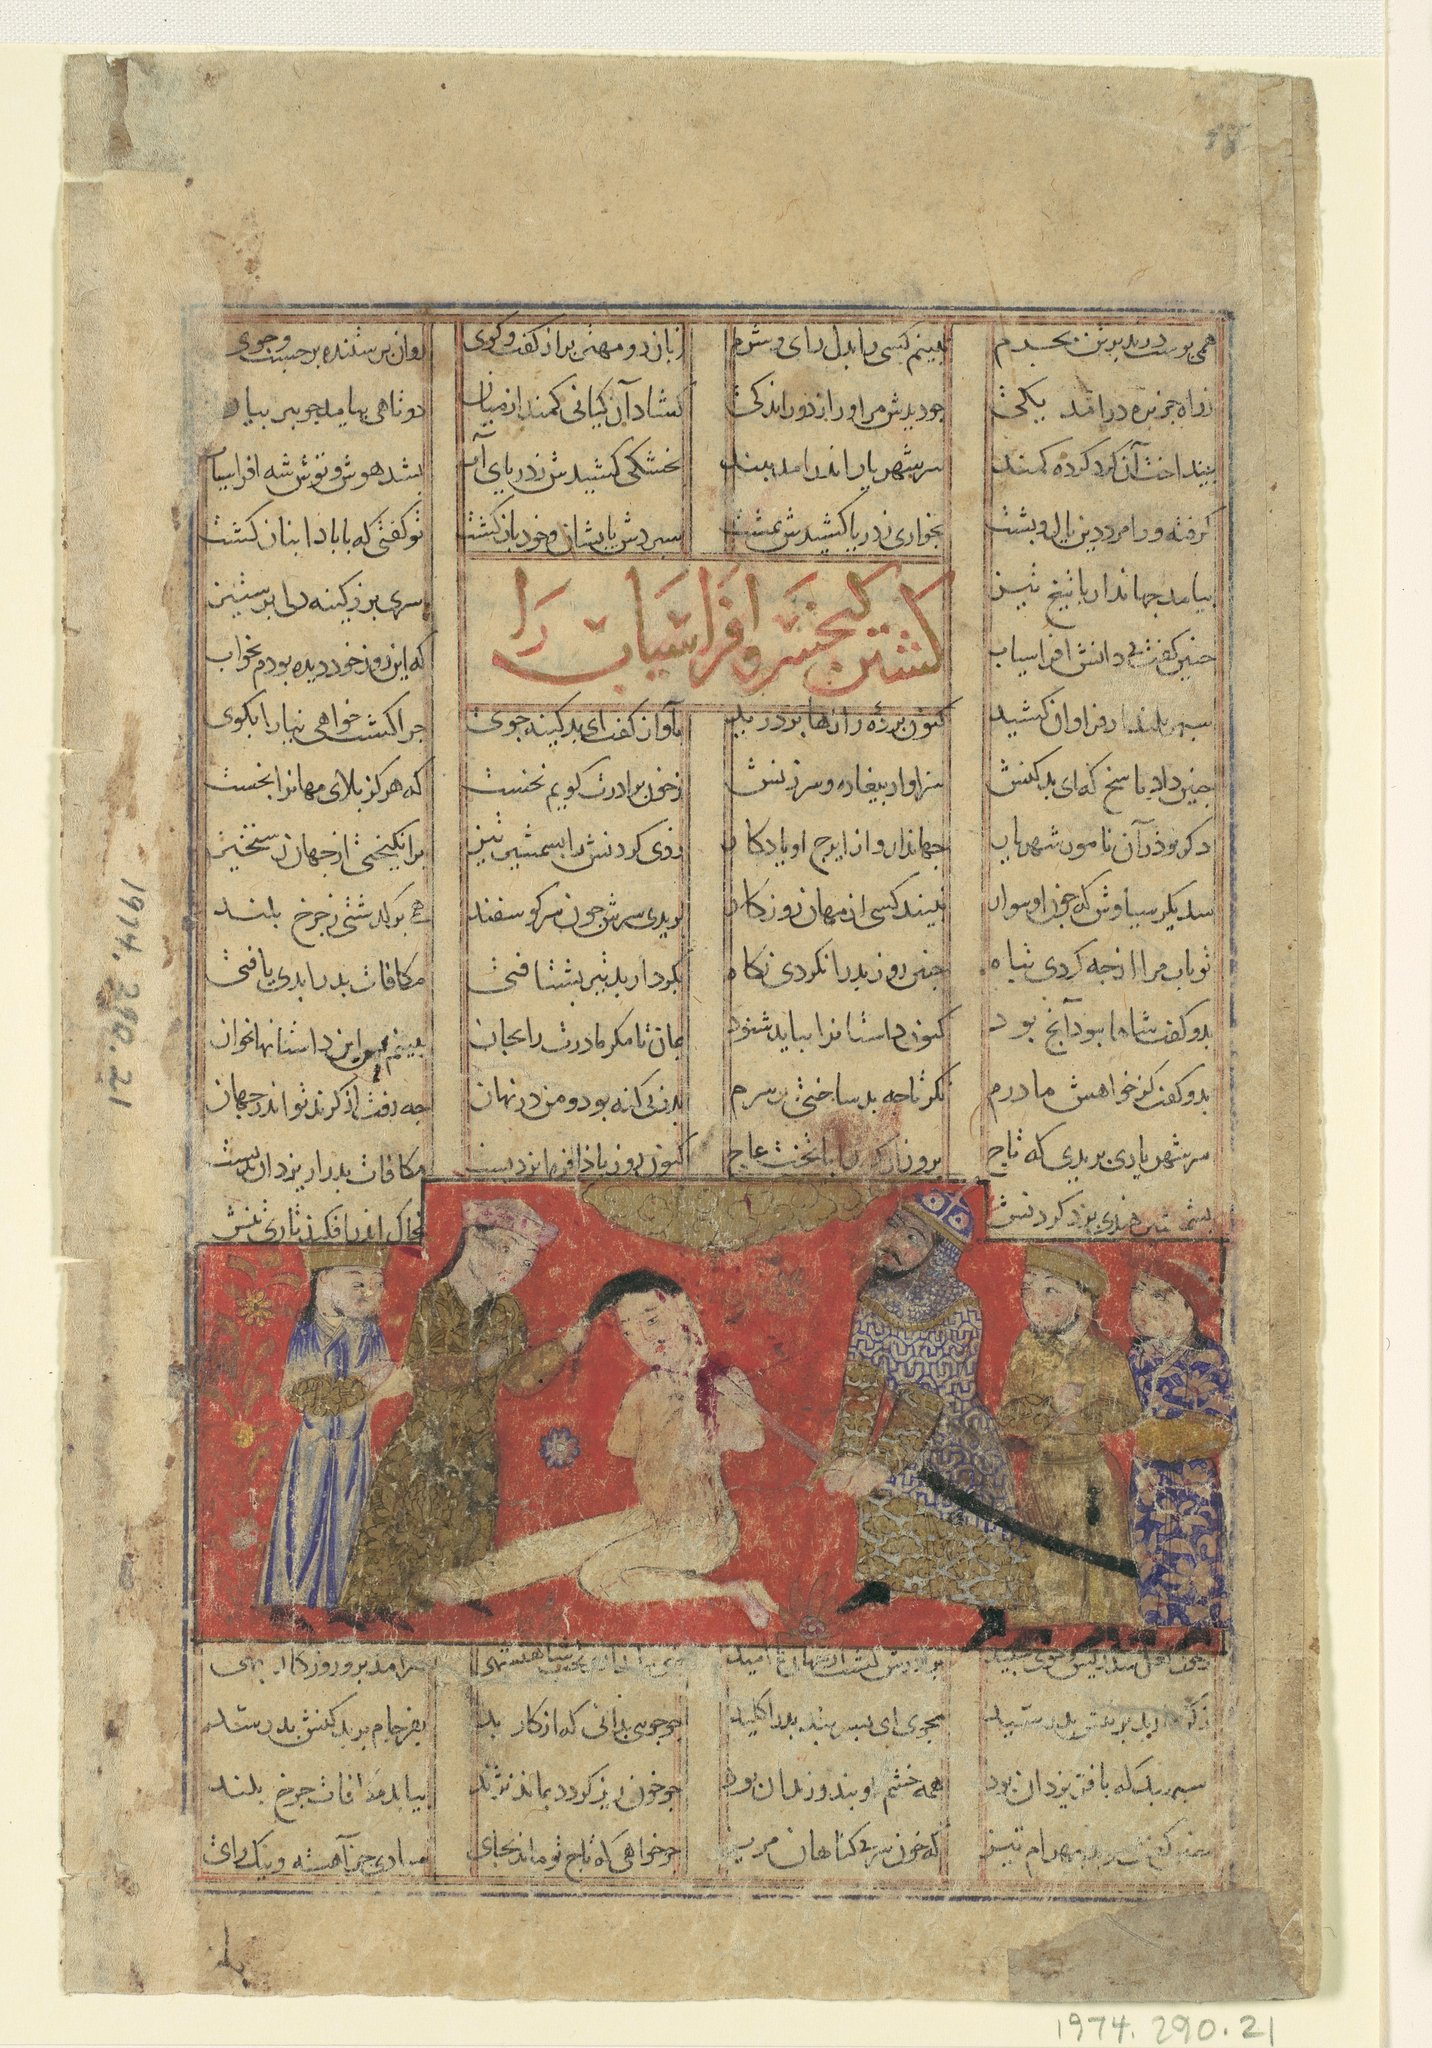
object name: folio from an illustrated manuscript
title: "Kai Khusrau Slays Afrasiyab", Folio from a Shahnama (Book of Kings)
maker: abu'l qasim firdausi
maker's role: author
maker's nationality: iranian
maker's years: 935-1020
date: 1330-1340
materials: gold, ink, paper, silver, watercolor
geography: iran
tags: kings,men,execution